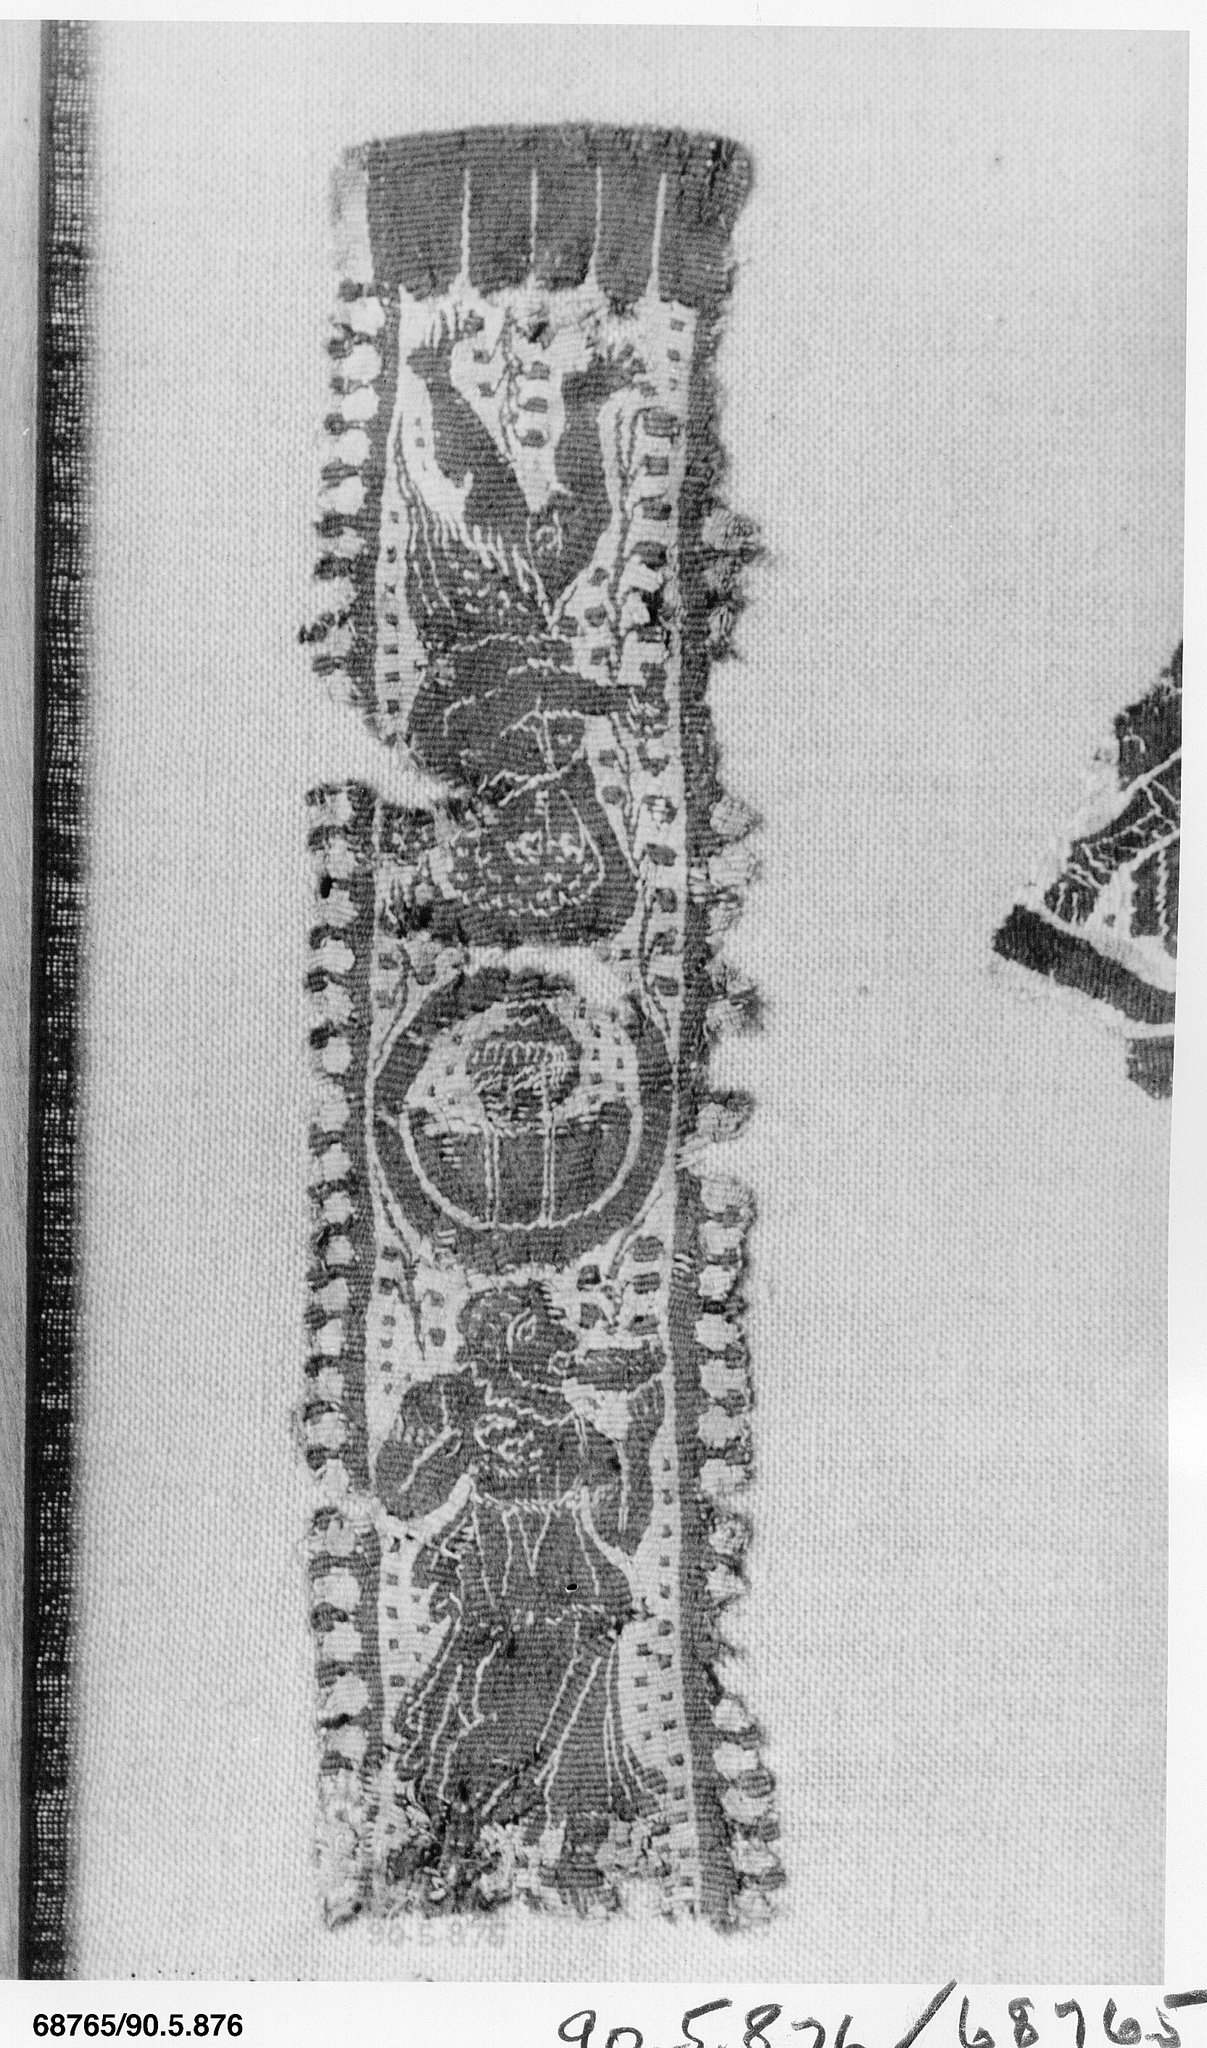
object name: band fragment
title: Fragment of a Band with Scenes from the Vintage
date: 301-600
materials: linen, wool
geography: egypt